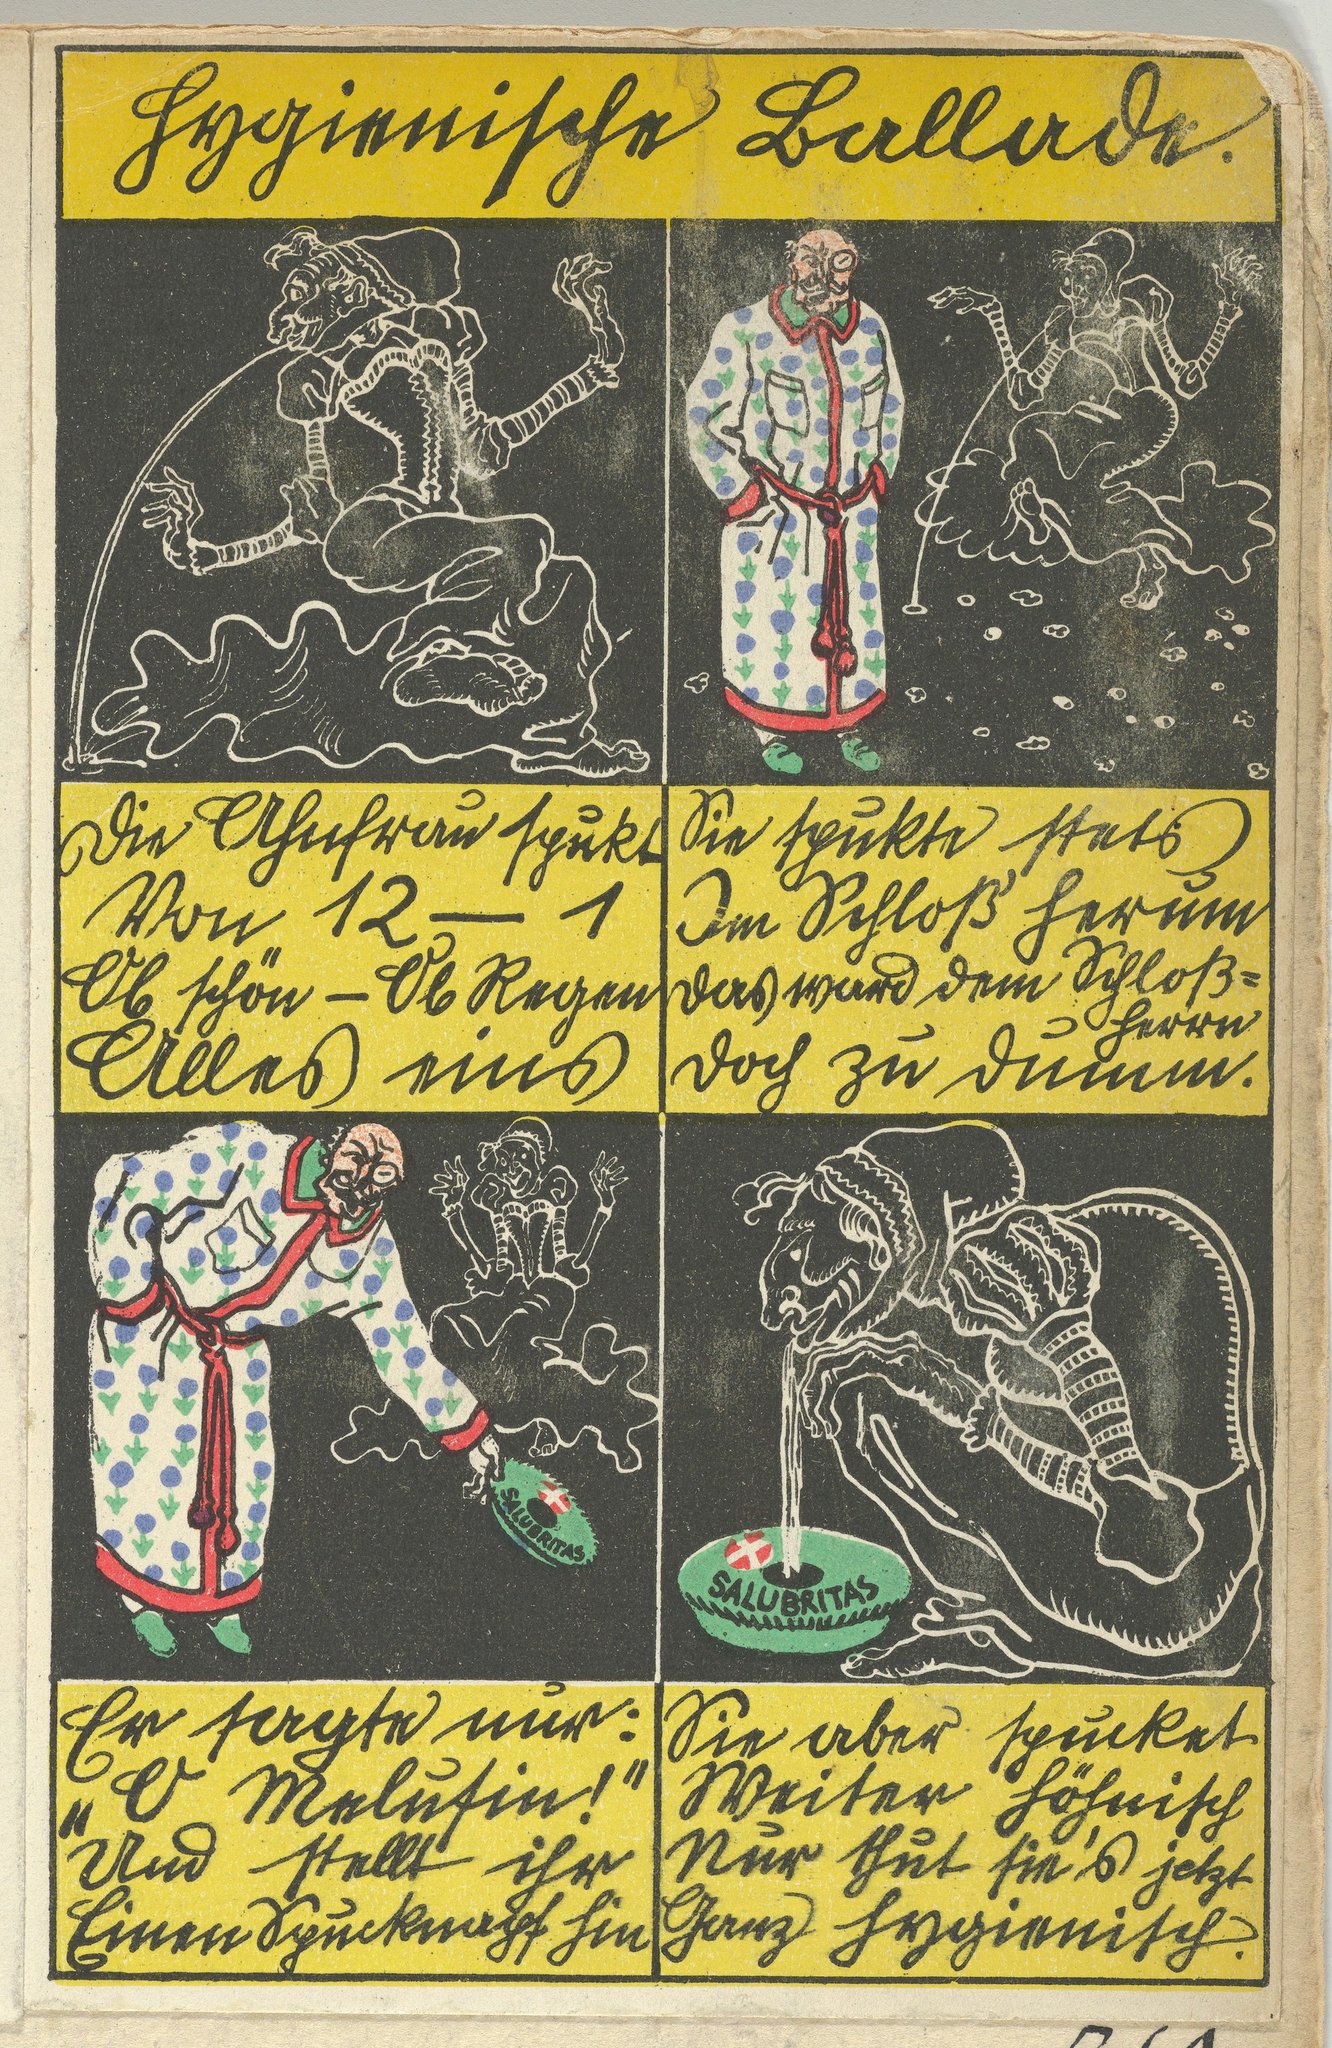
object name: print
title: Hygienic Ballad (Hygienische Ballade)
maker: moriz jung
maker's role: artist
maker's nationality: austrian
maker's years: 1885-1915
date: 1911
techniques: lithograph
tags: satire,men,women